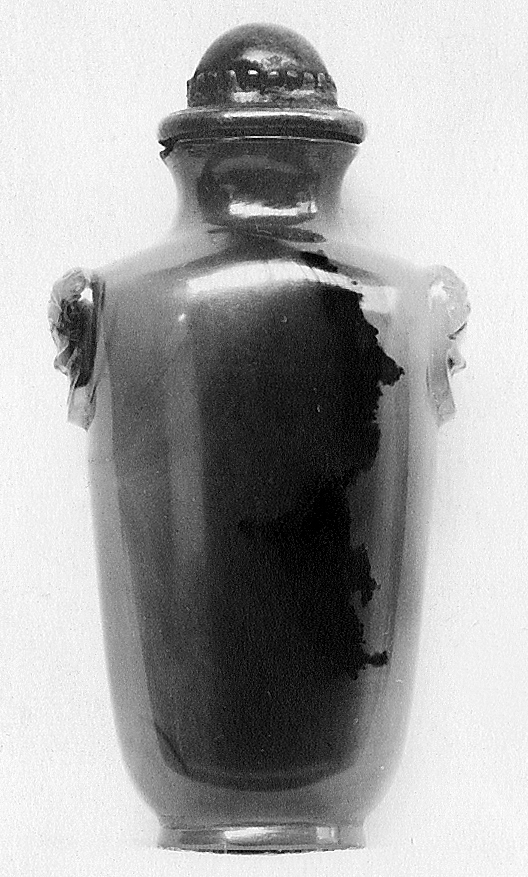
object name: snuff bottle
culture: chinese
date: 1801-1900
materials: stone